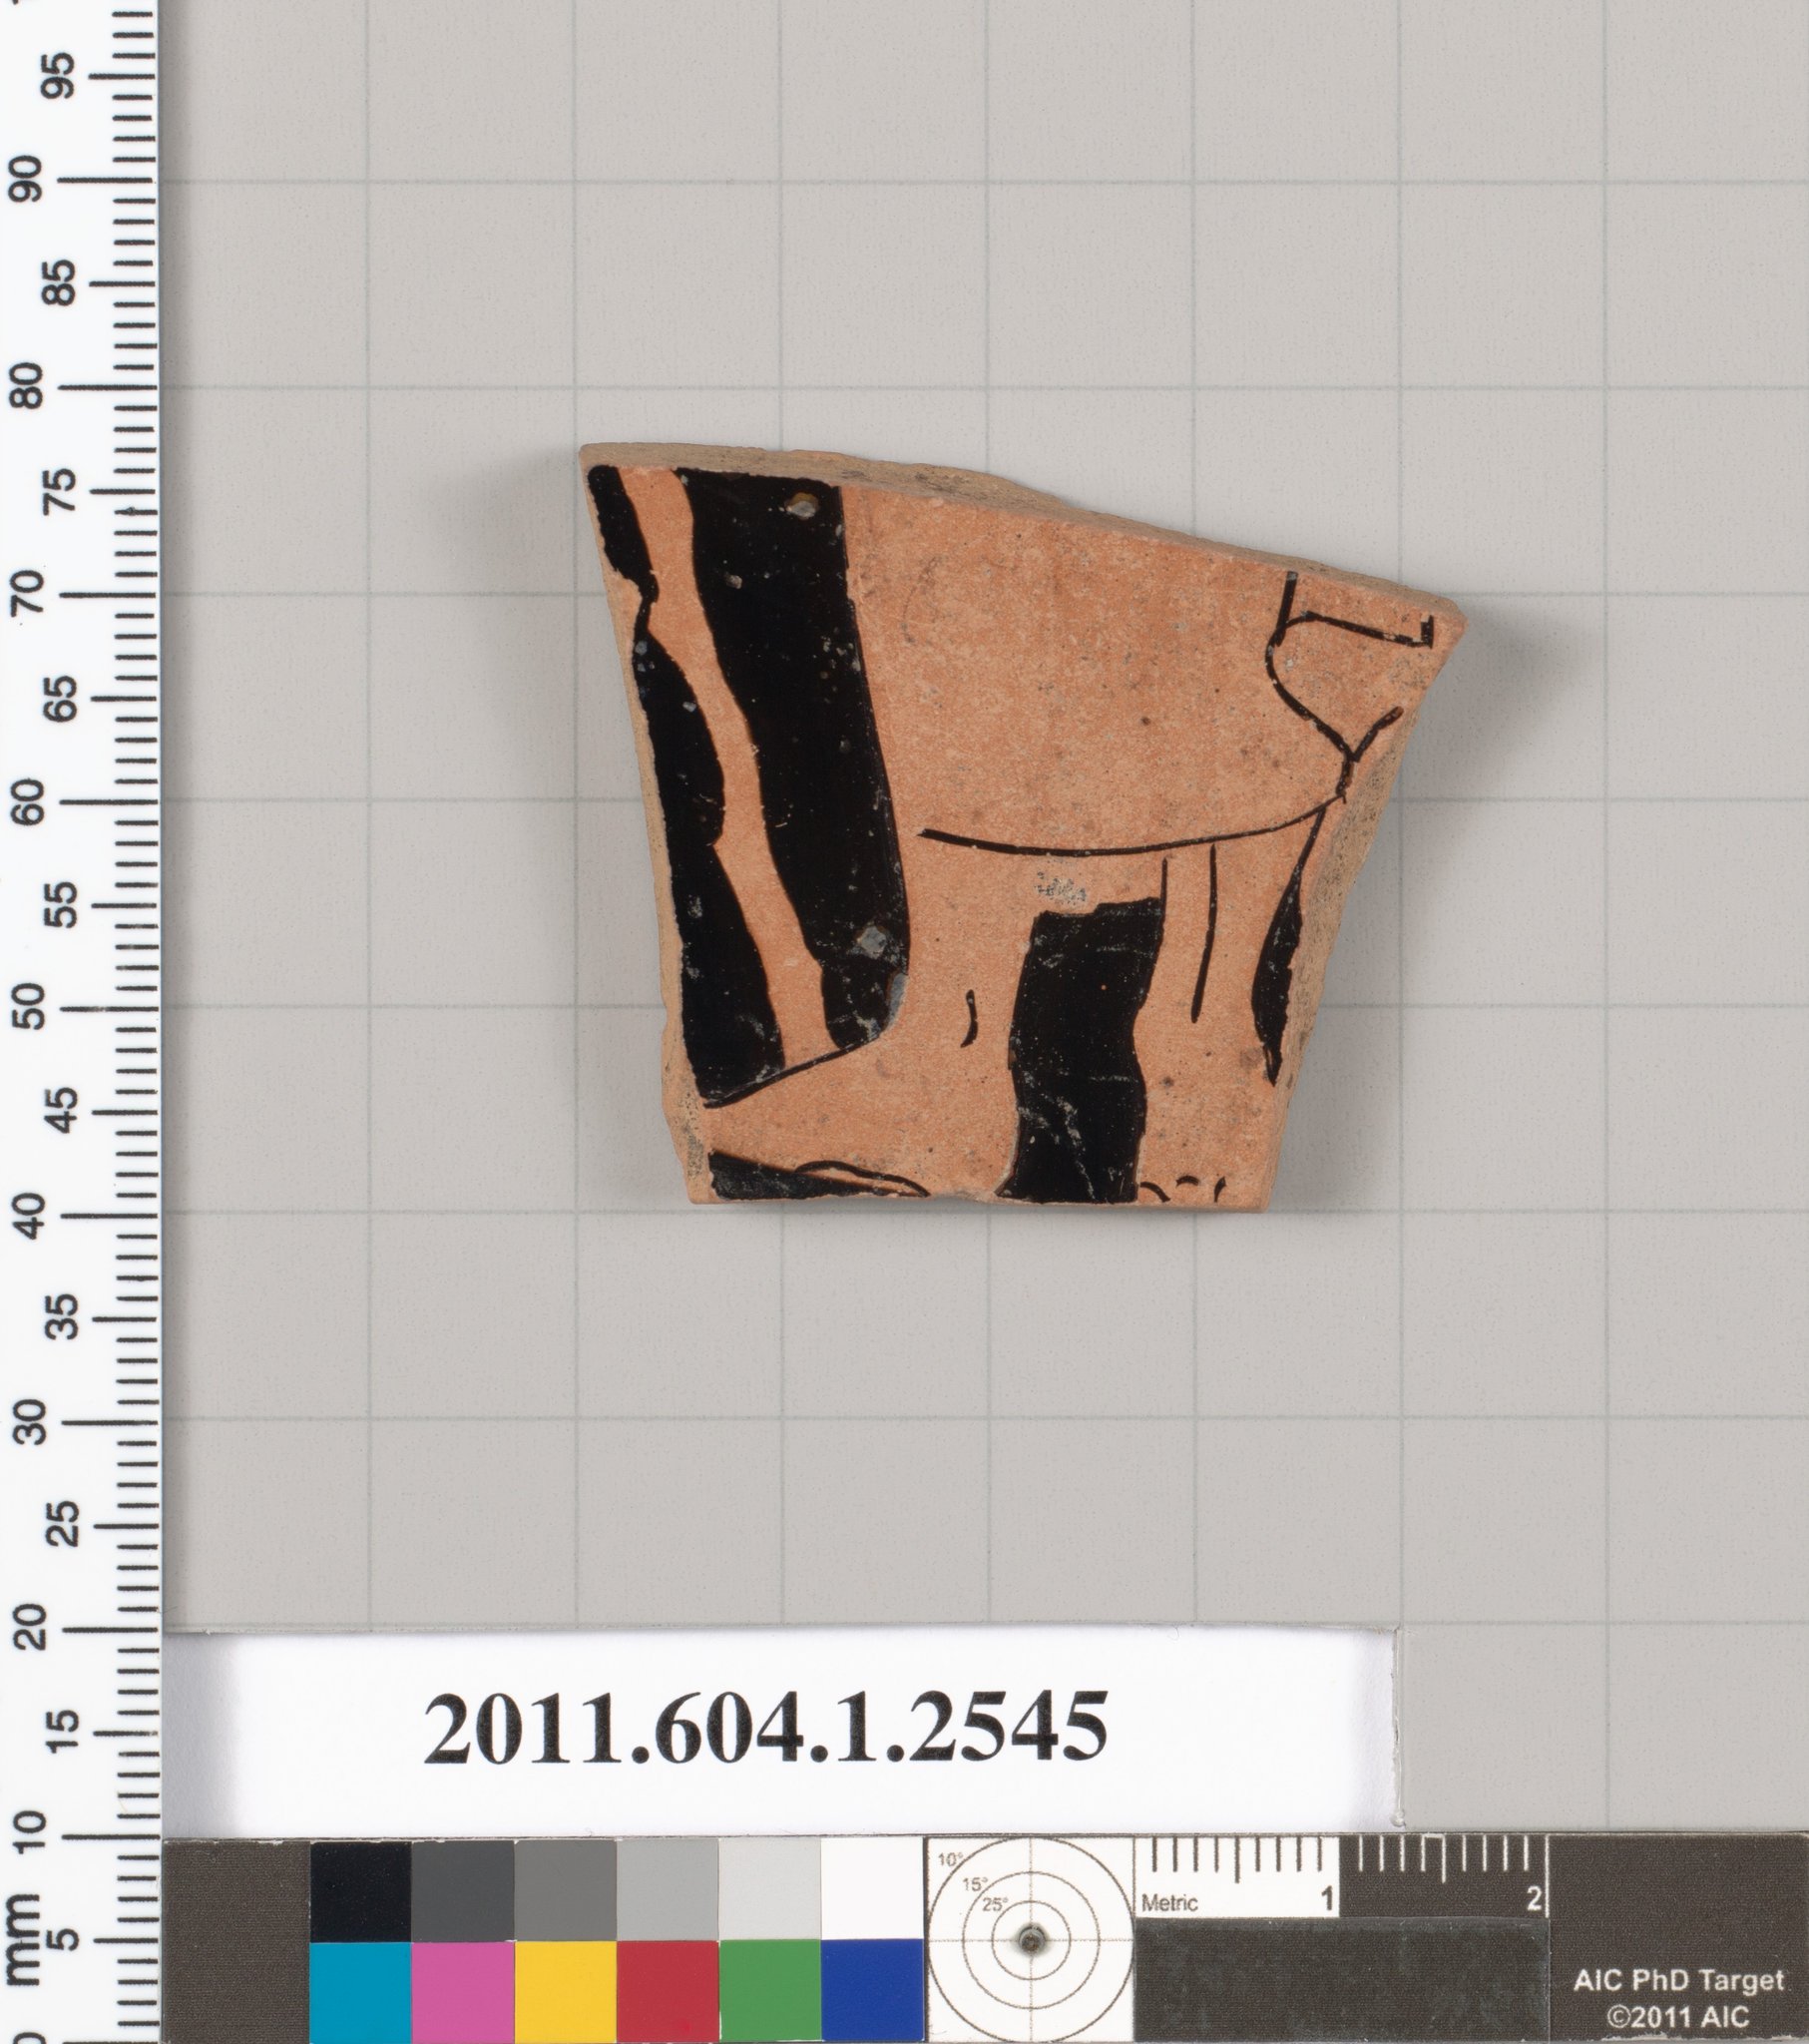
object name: kylix fragment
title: Terracotta fragment of a kylix (drinking cup)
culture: greek, attic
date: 475-451 BCE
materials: terracotta